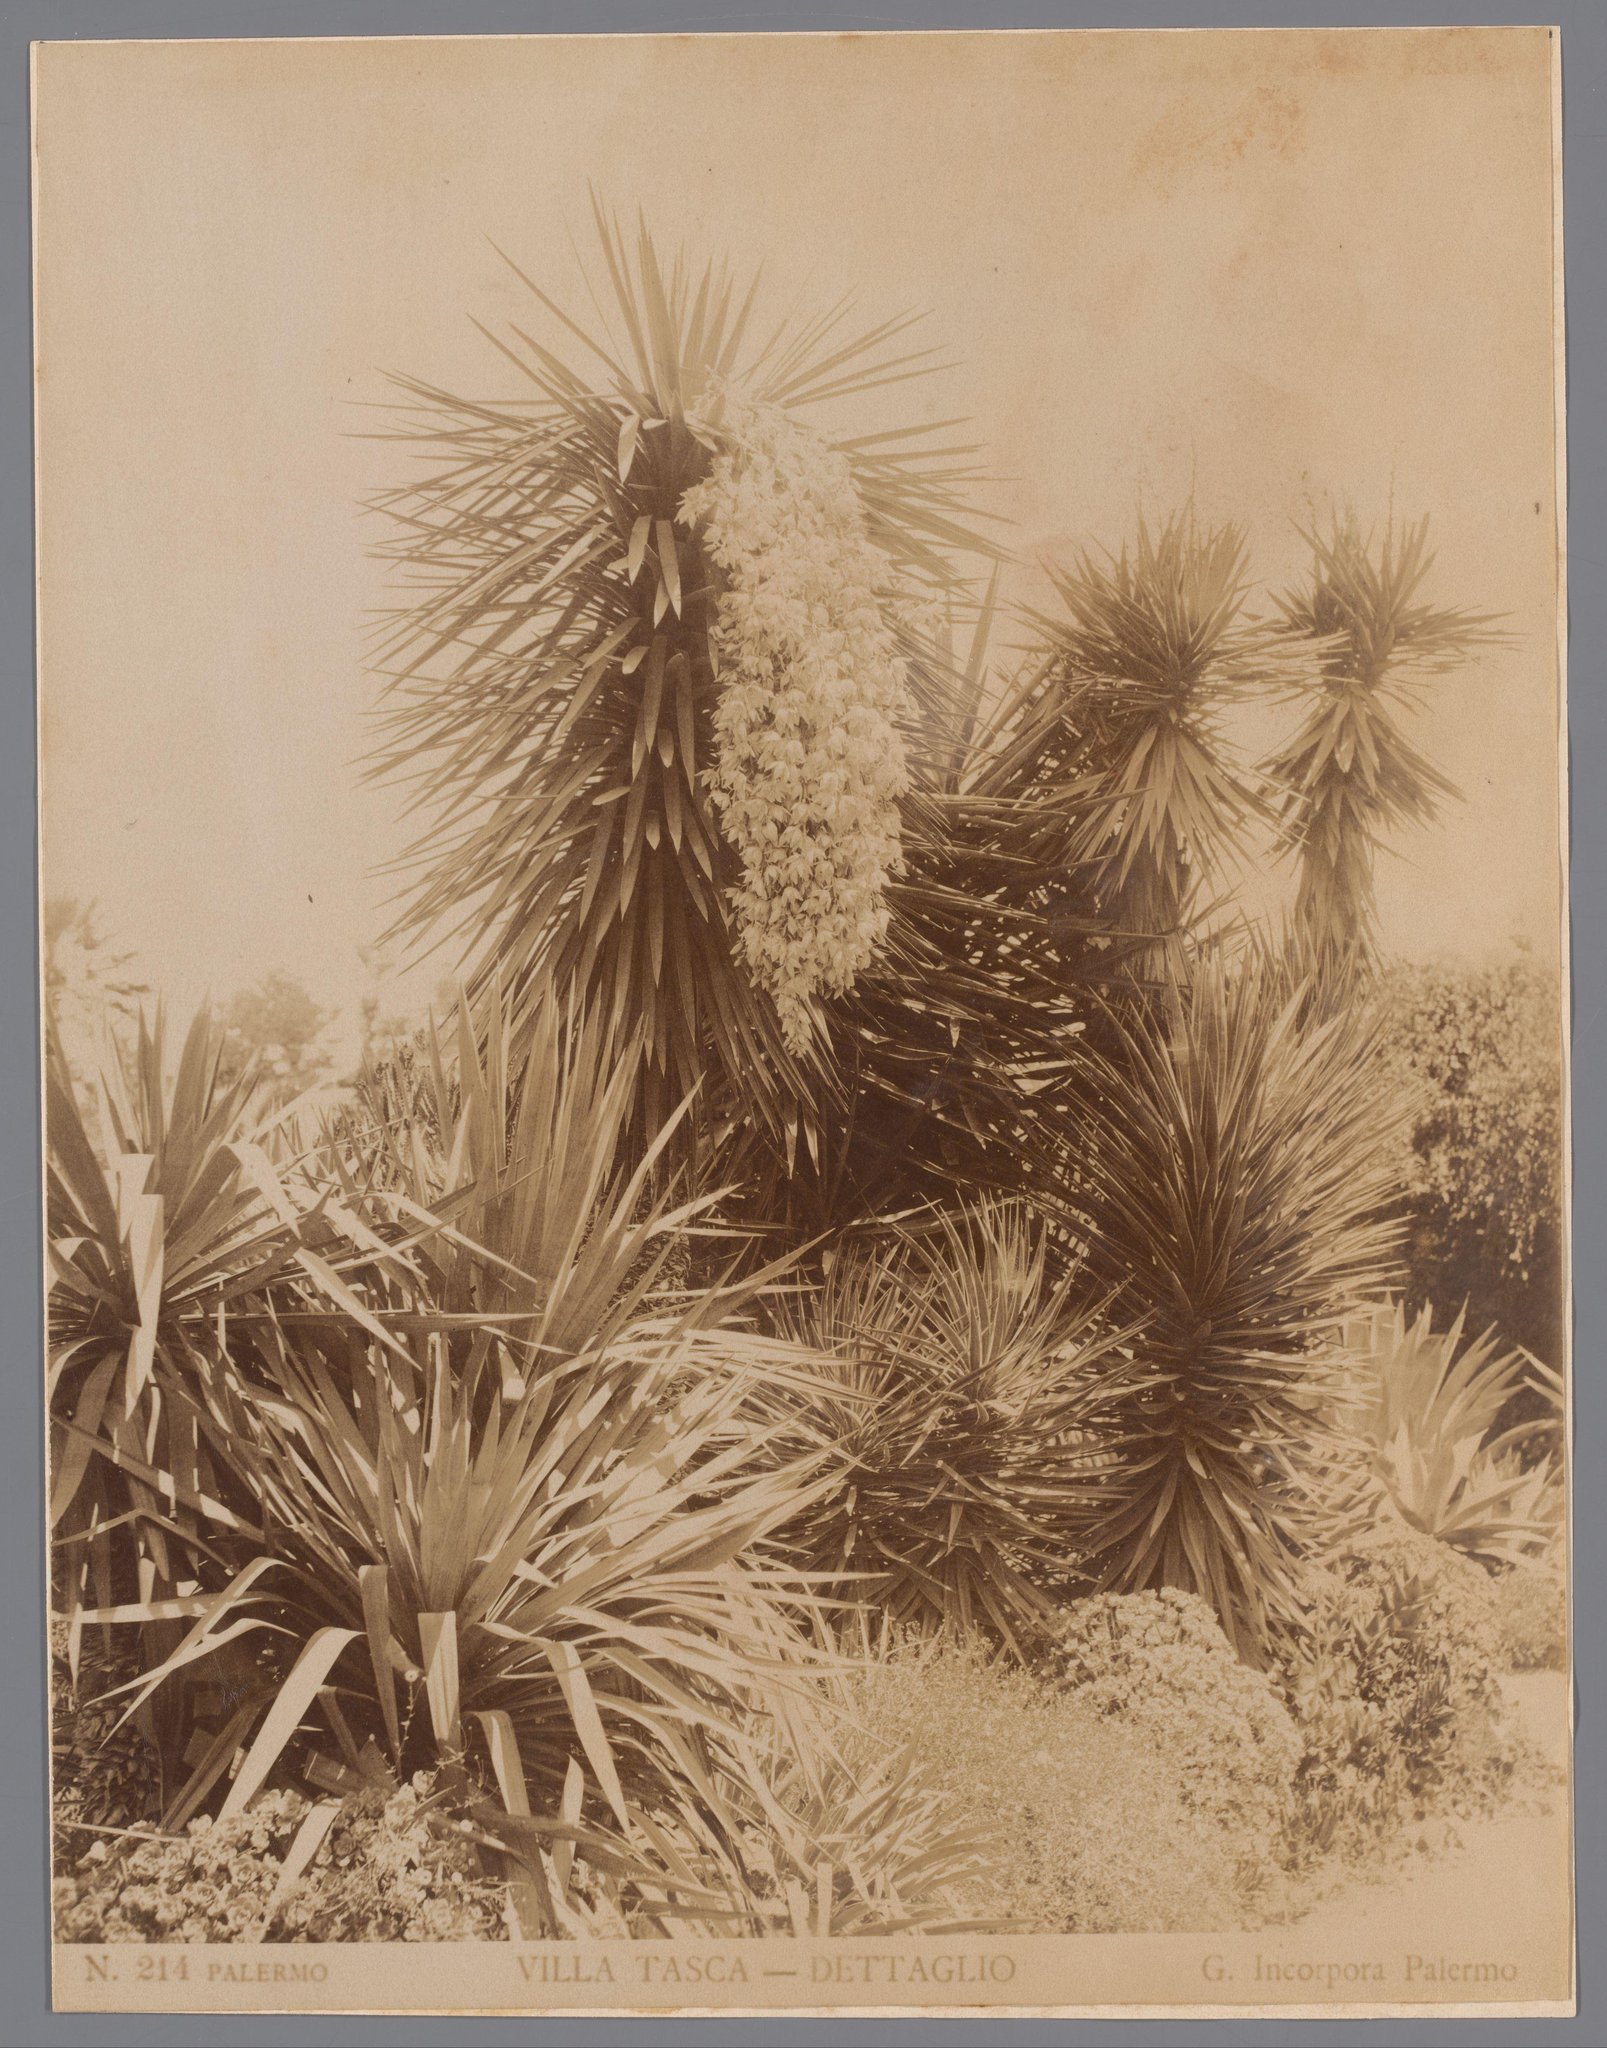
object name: photograph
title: Bomen en struikgewas in de tuin van Villa Tasca in Palermo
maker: giuseppe incorpora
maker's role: fotograaf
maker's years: 1834-1914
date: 1856-1914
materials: paper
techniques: albumen print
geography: palermo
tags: garden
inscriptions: number: ‘N. 214’